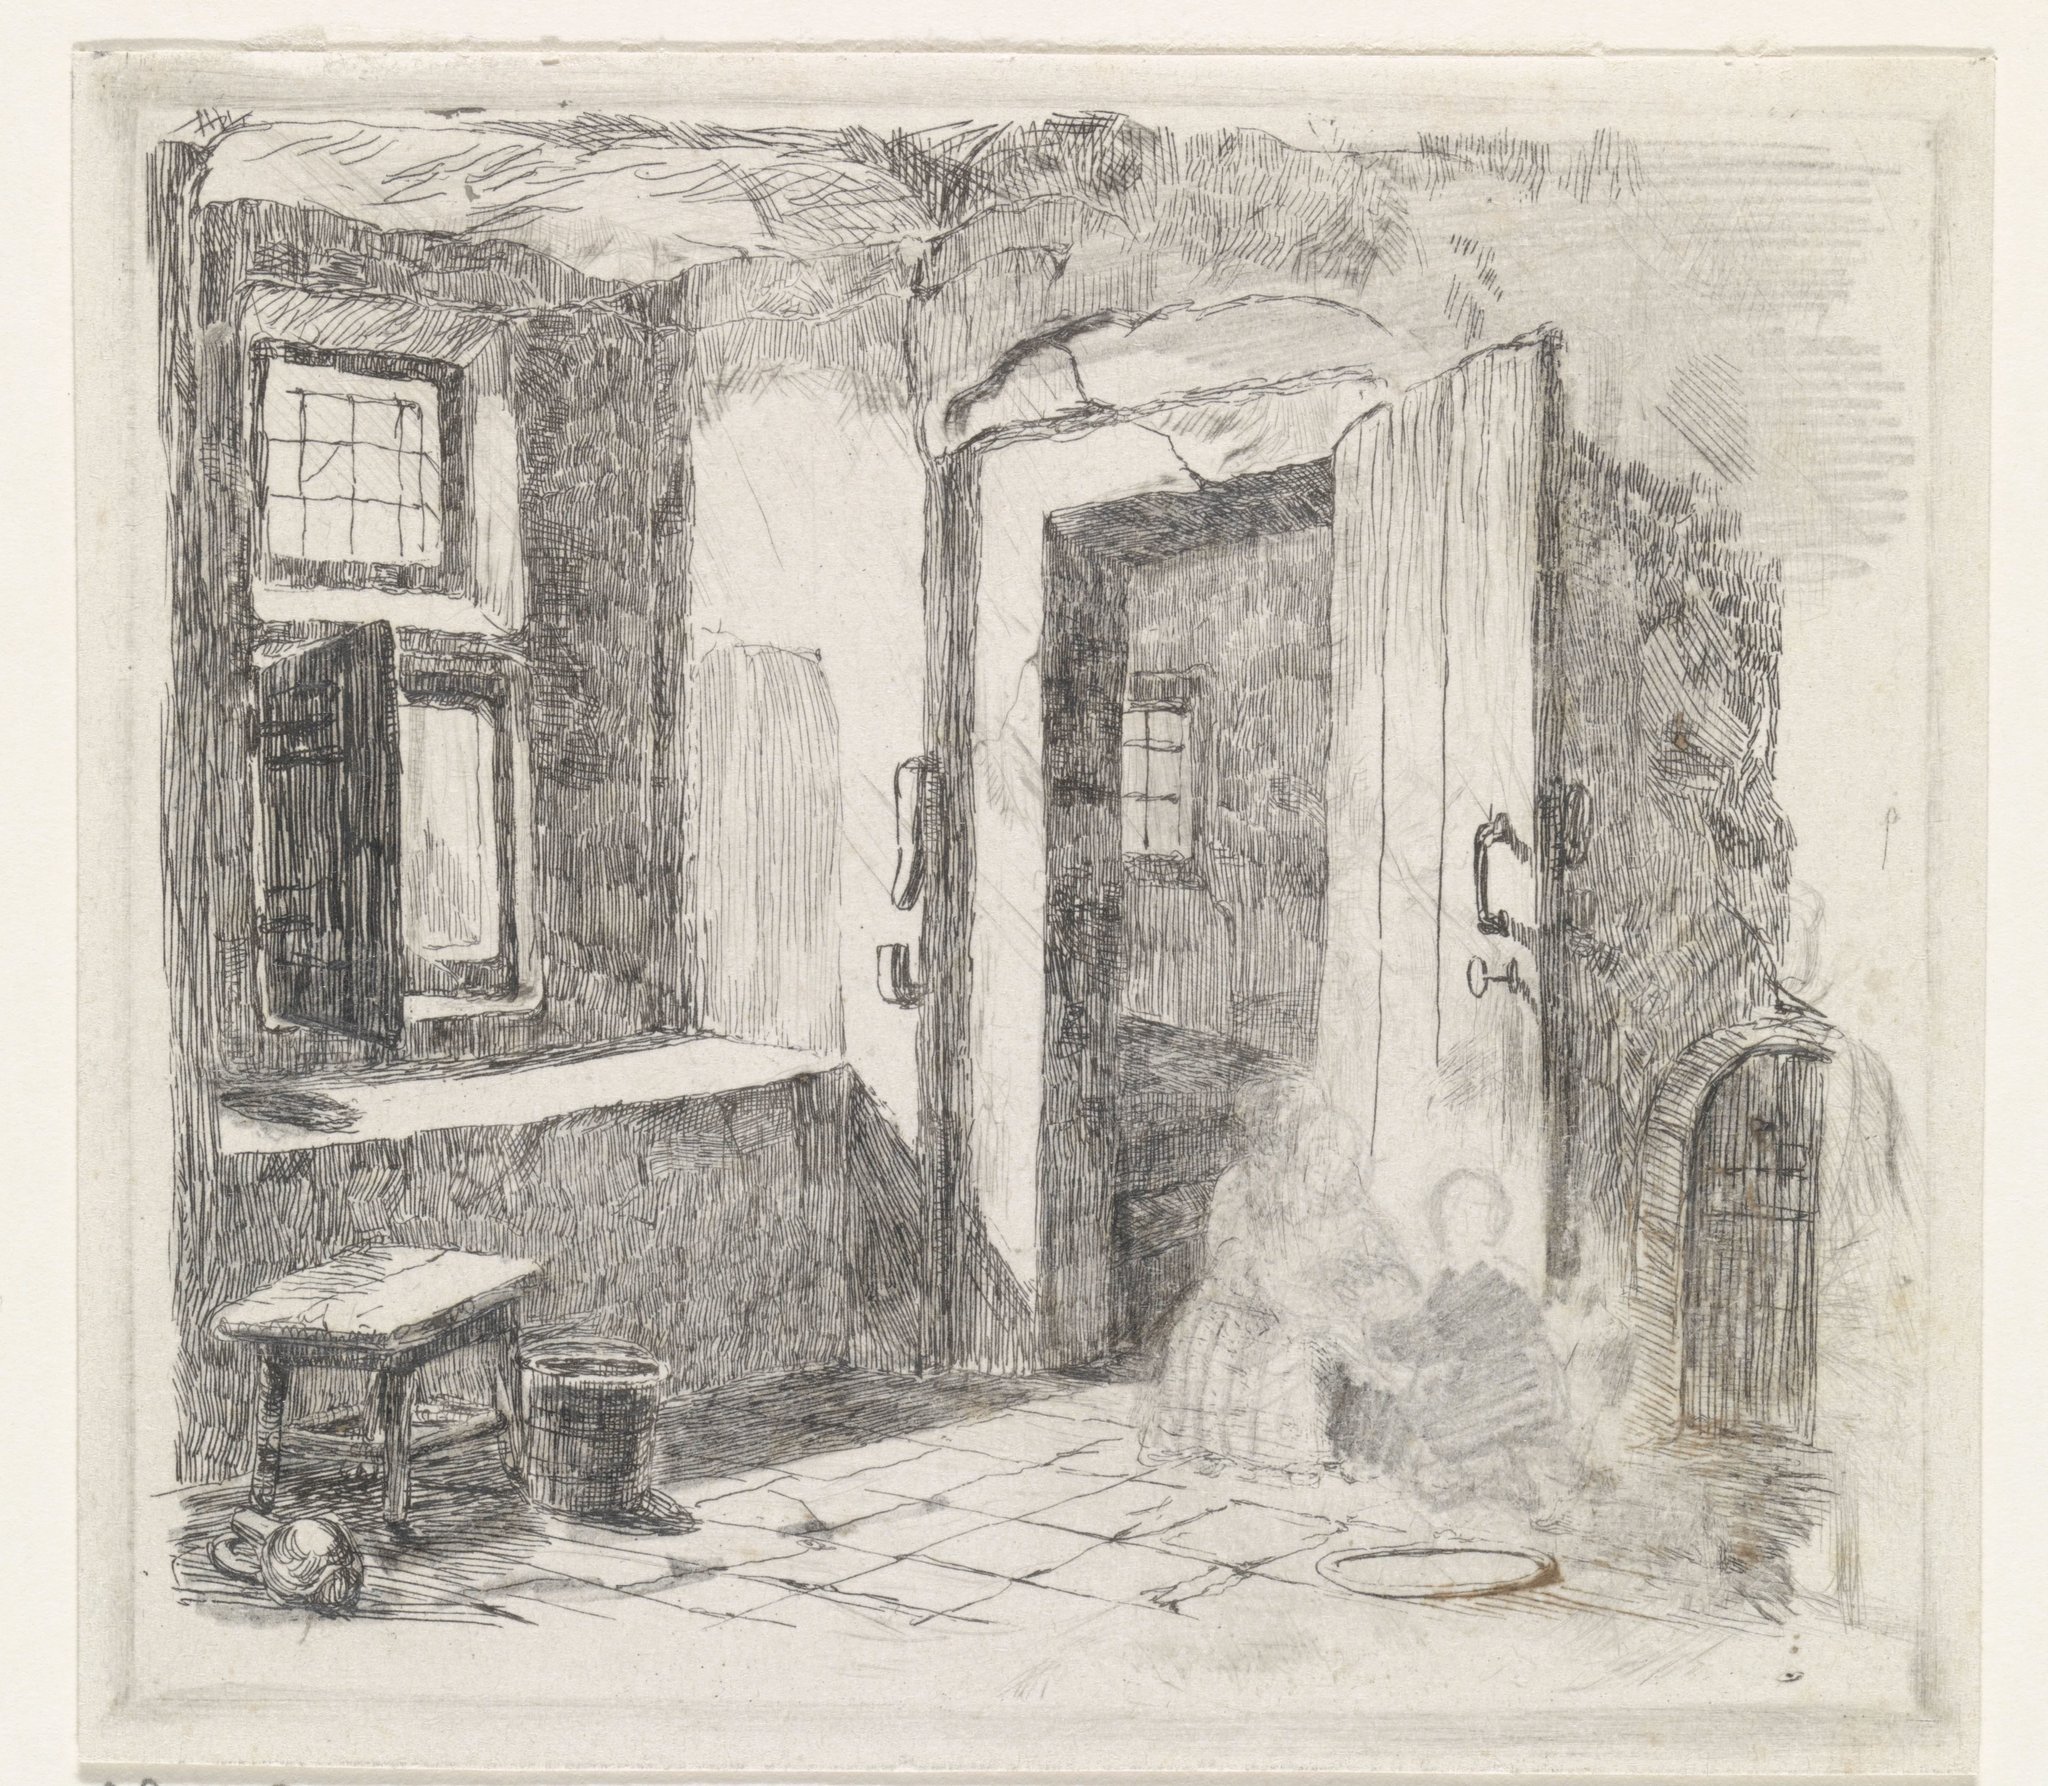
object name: print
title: Interieur met openstaande deur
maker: david van der kellen (1827-1895)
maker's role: draughtsman, print maker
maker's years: 1827-1895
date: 1837-1882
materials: paper, pencil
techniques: drypoint, etching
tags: key, interior of the house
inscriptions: collector's mark: Lugt 2228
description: Interieur van een vertrek met openstaande deur, waarin een sleutel steekt. Bij de deur zijn twee figuren weergegeven. Aan de linkerzijde van het vertrek staan een bankje, een kruik en een emmer.